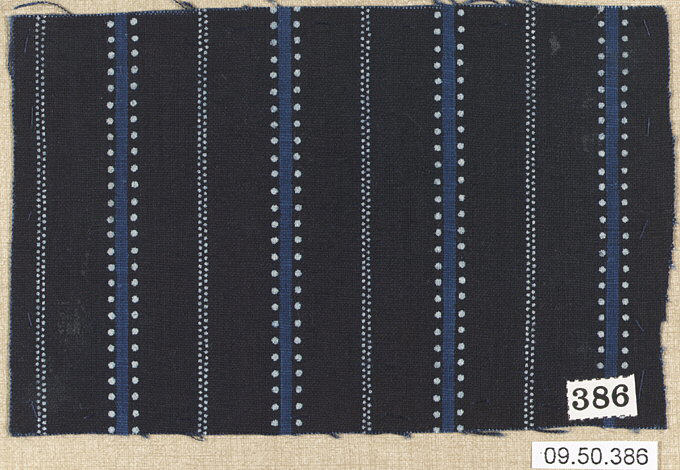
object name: piece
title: Piece (one of 116)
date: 1801-1900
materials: cotton